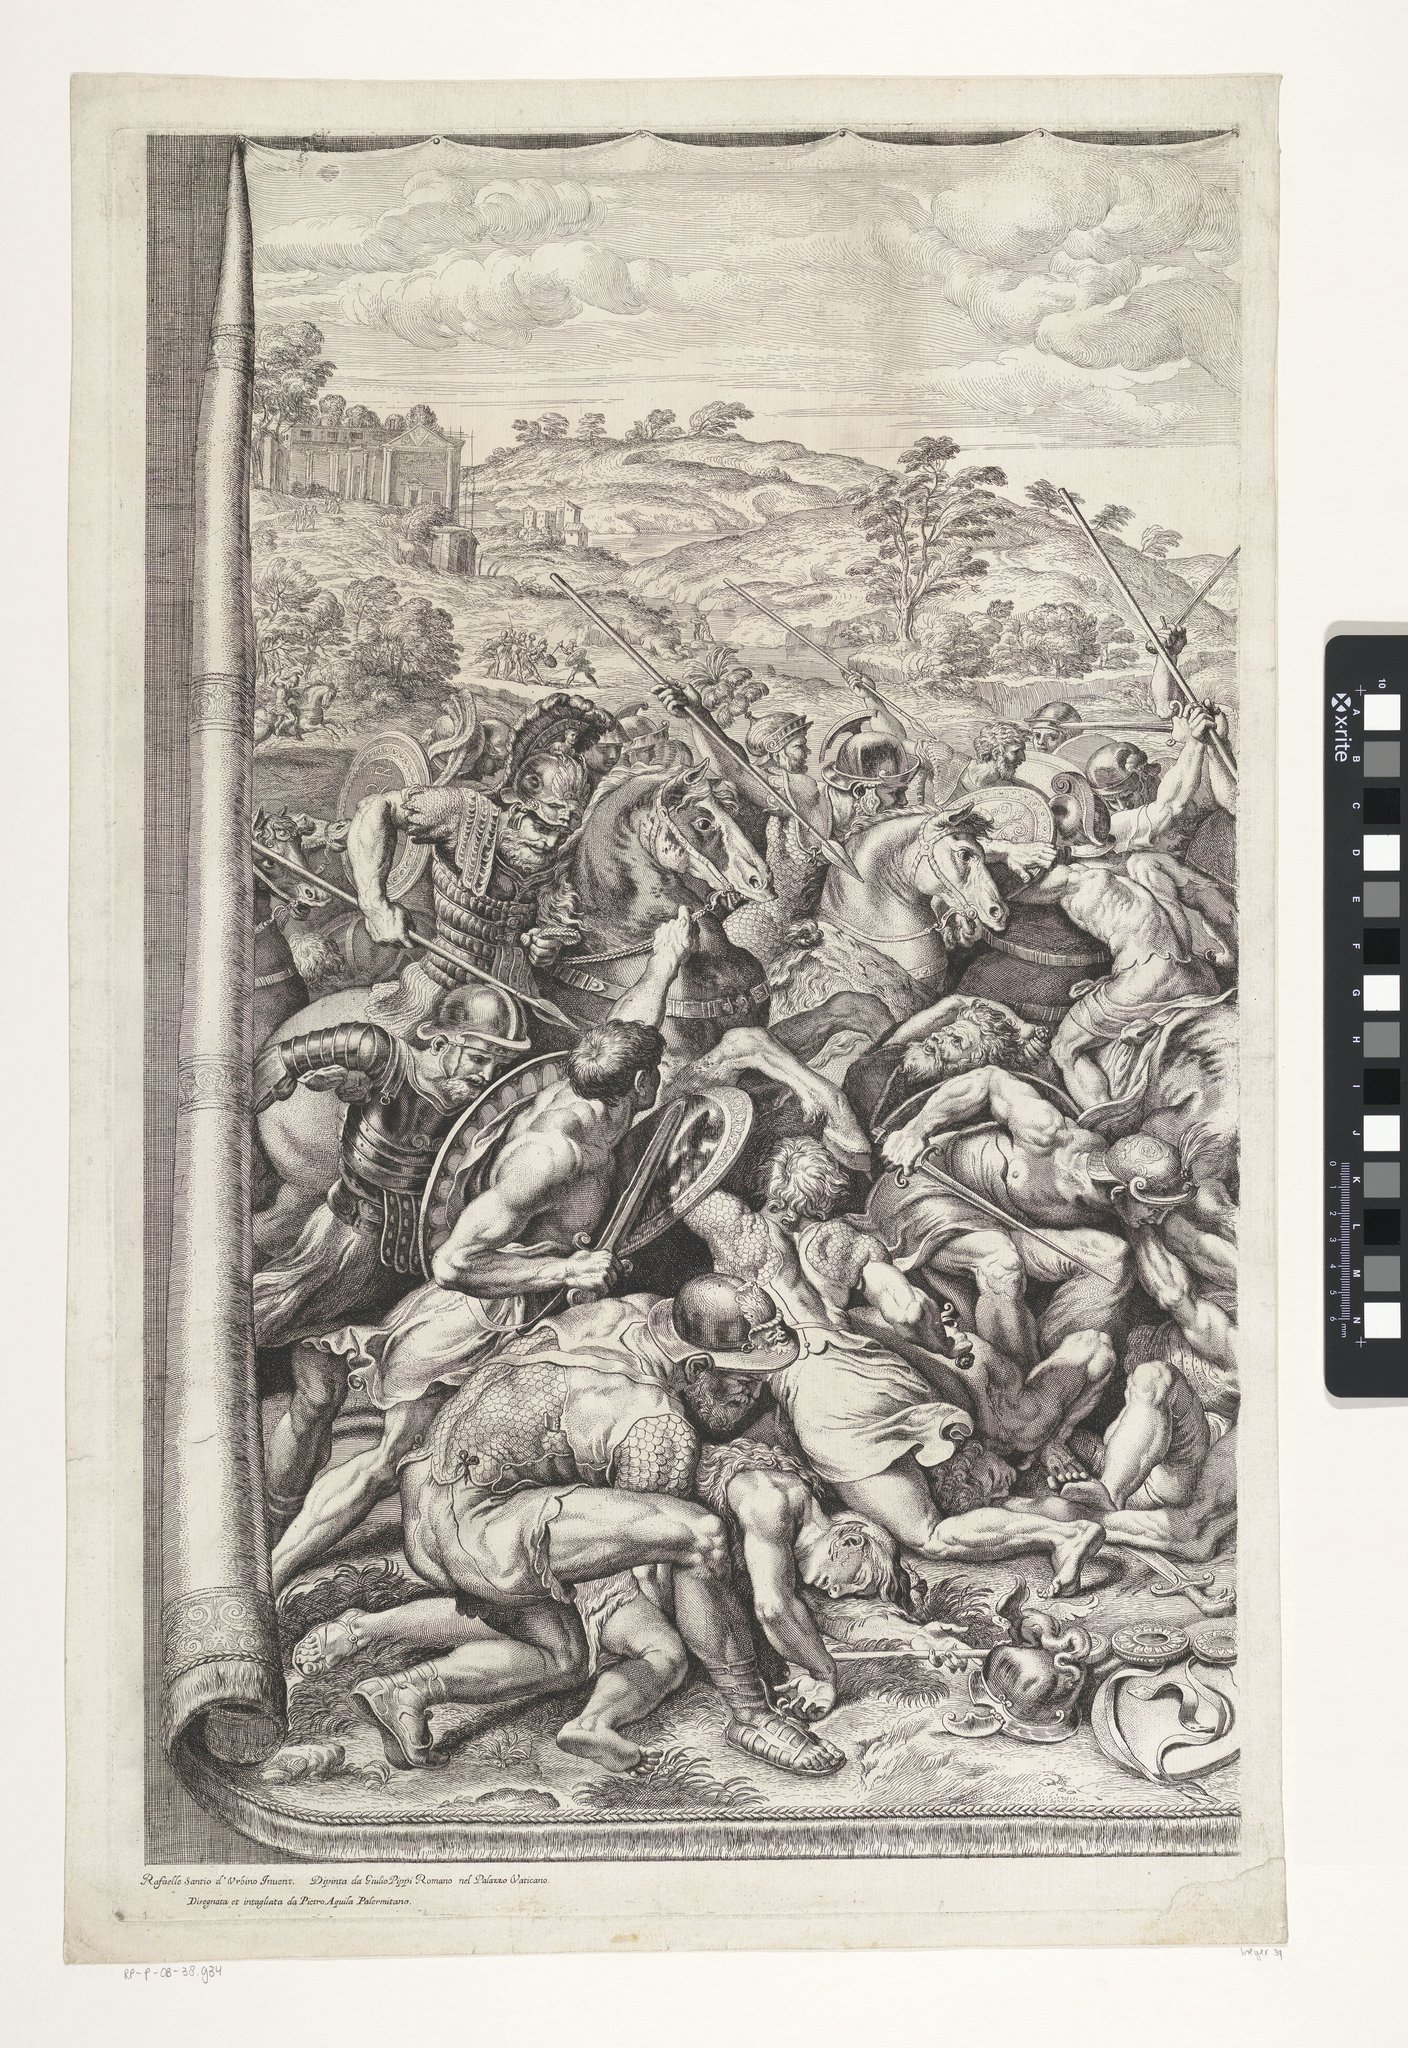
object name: print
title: Slag bij de Milvische brug (linker blad)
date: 1683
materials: paper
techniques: etching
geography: italy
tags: the battle of the milvian bridge (saxa rubra): st. constantine on horseback confronts maxentius; a cross appears in the sky with in fiery letters 'in hoc signo vinces' (the raised standards of the roman soldiers carry a cross or the chi-rho monogram), warfare; military affairs (+ cavalry, horsemen), the soldier; the soldier's life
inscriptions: collector's mark: Lugt 240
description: Gevechtsscène in een landschap: slag bij de Milvische brug. De soldaten van Constantijn in gevecht met de soldaten van Maxentius. Dode lichamen liggen op de grond. Soldaten te paard verdrinken in de rivier.